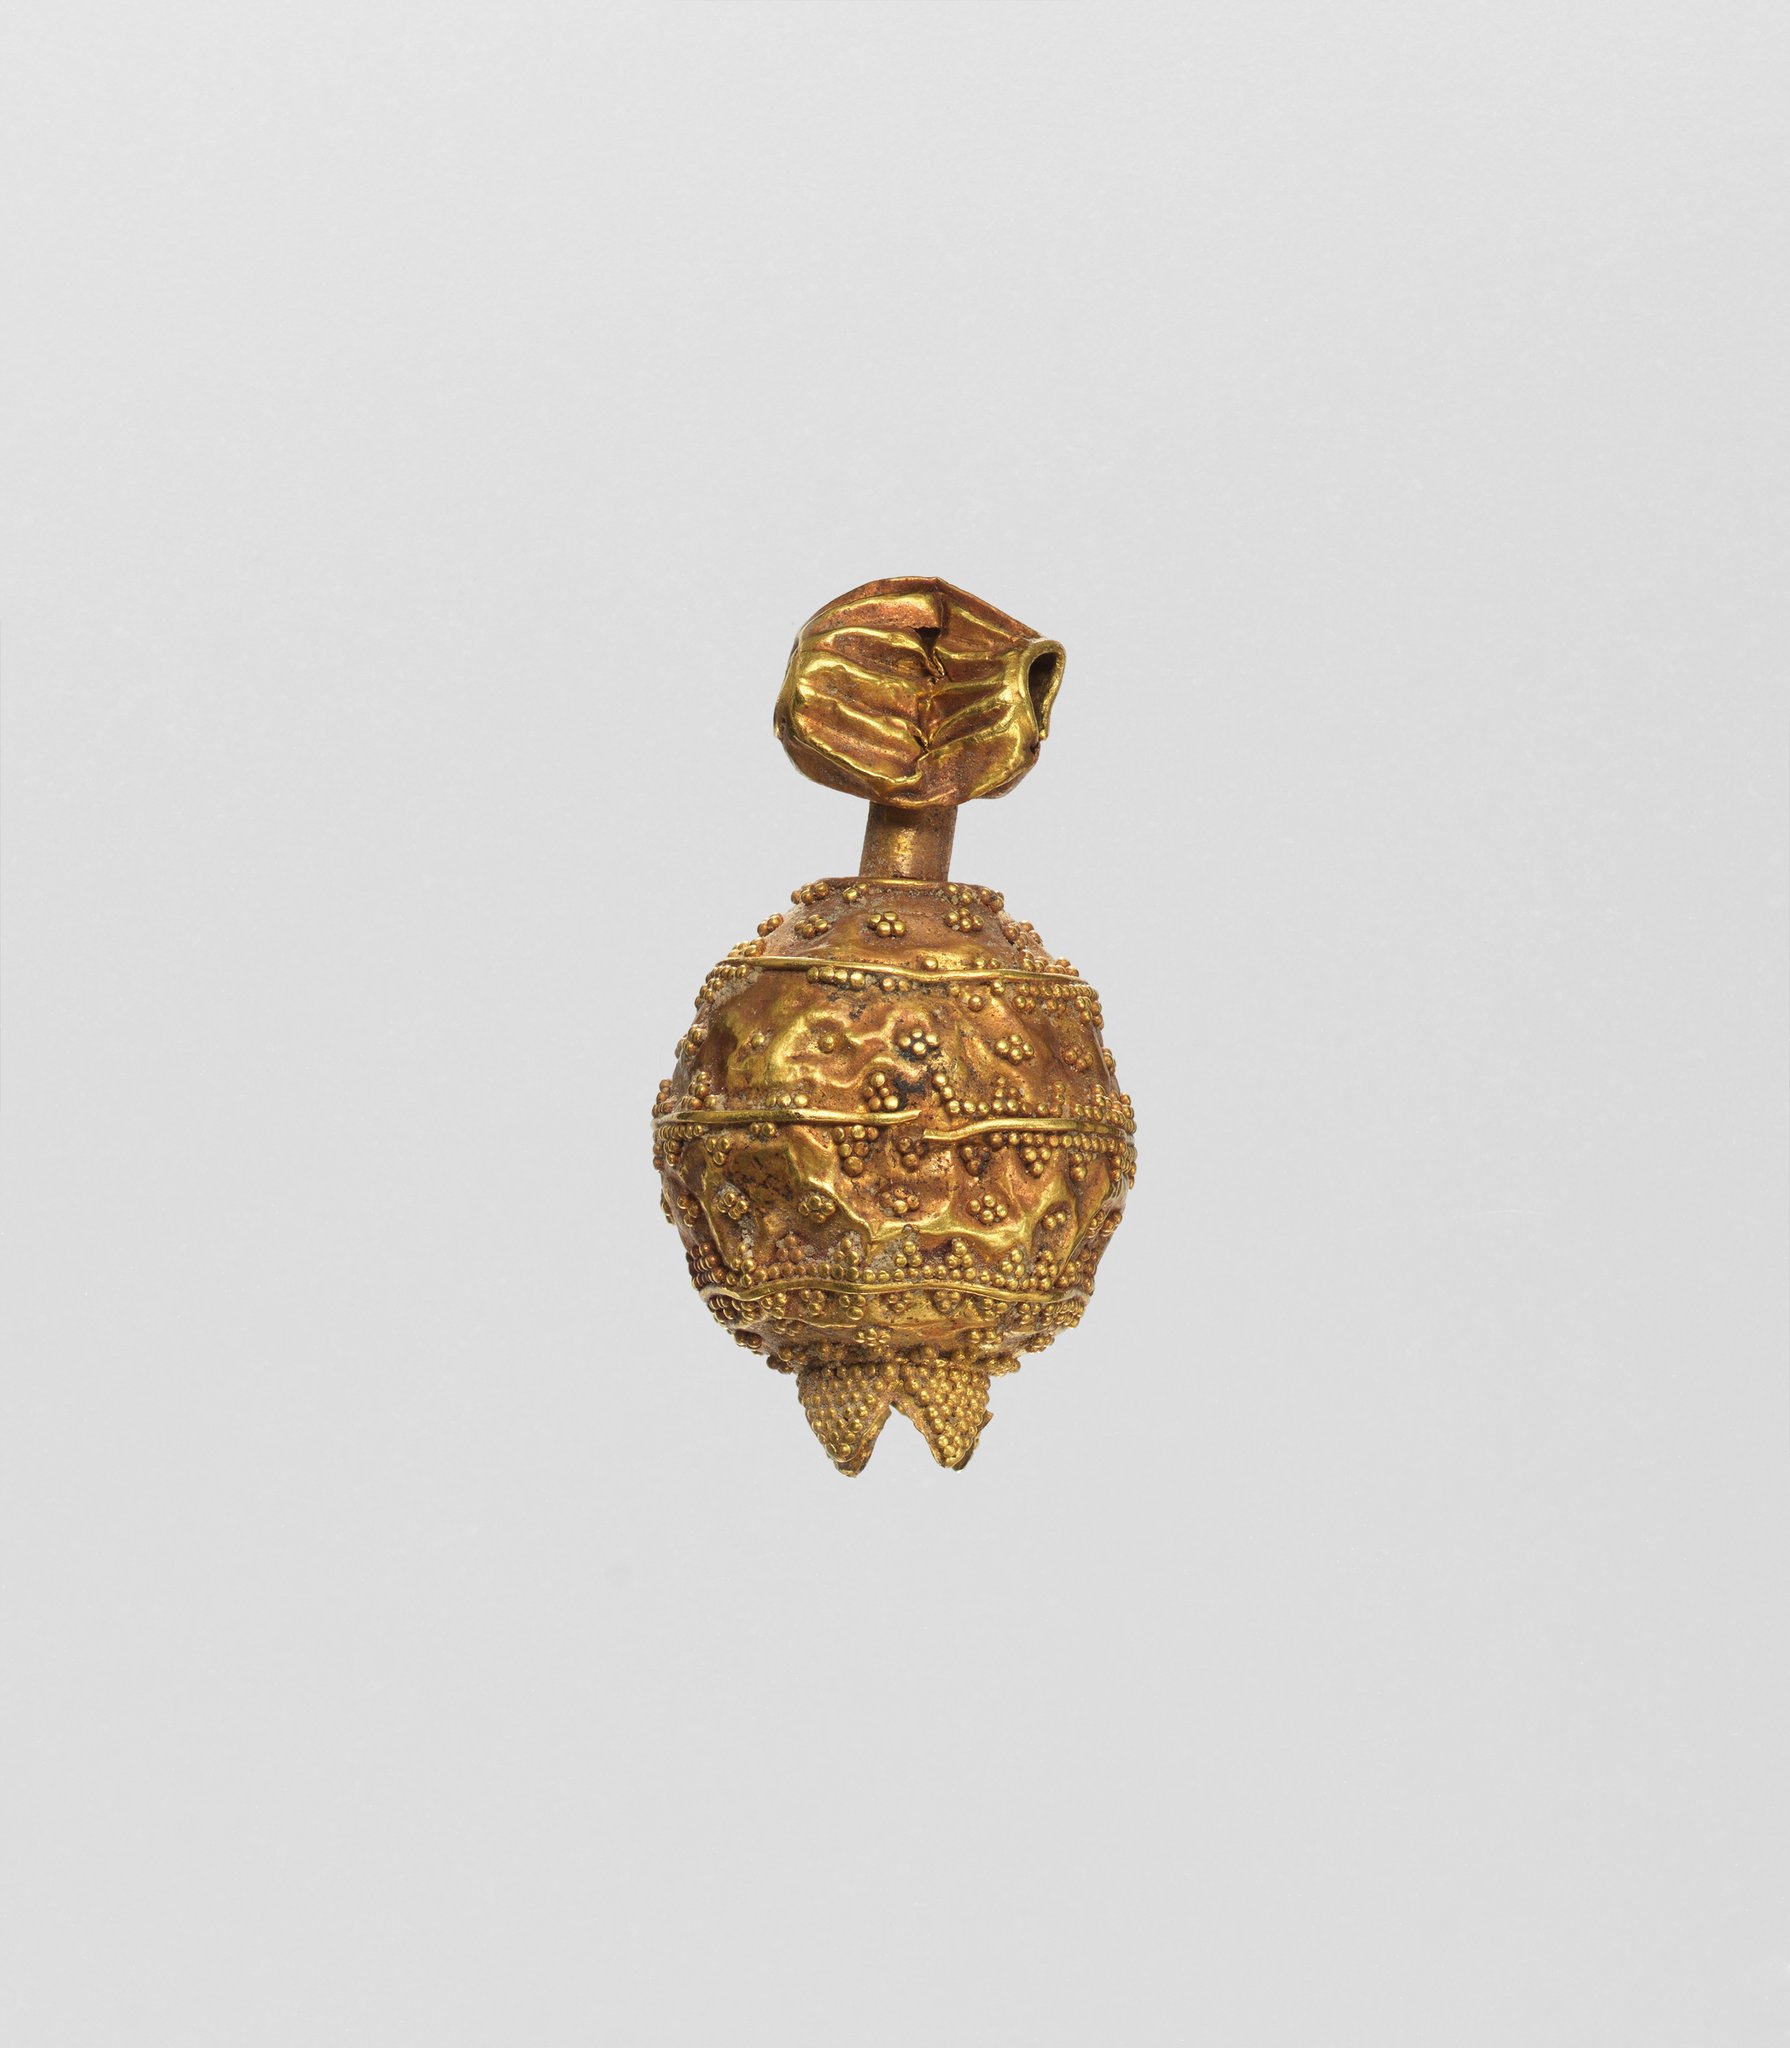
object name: pendant, granulation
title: Pendant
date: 332-330 BCE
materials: gold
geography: egypt